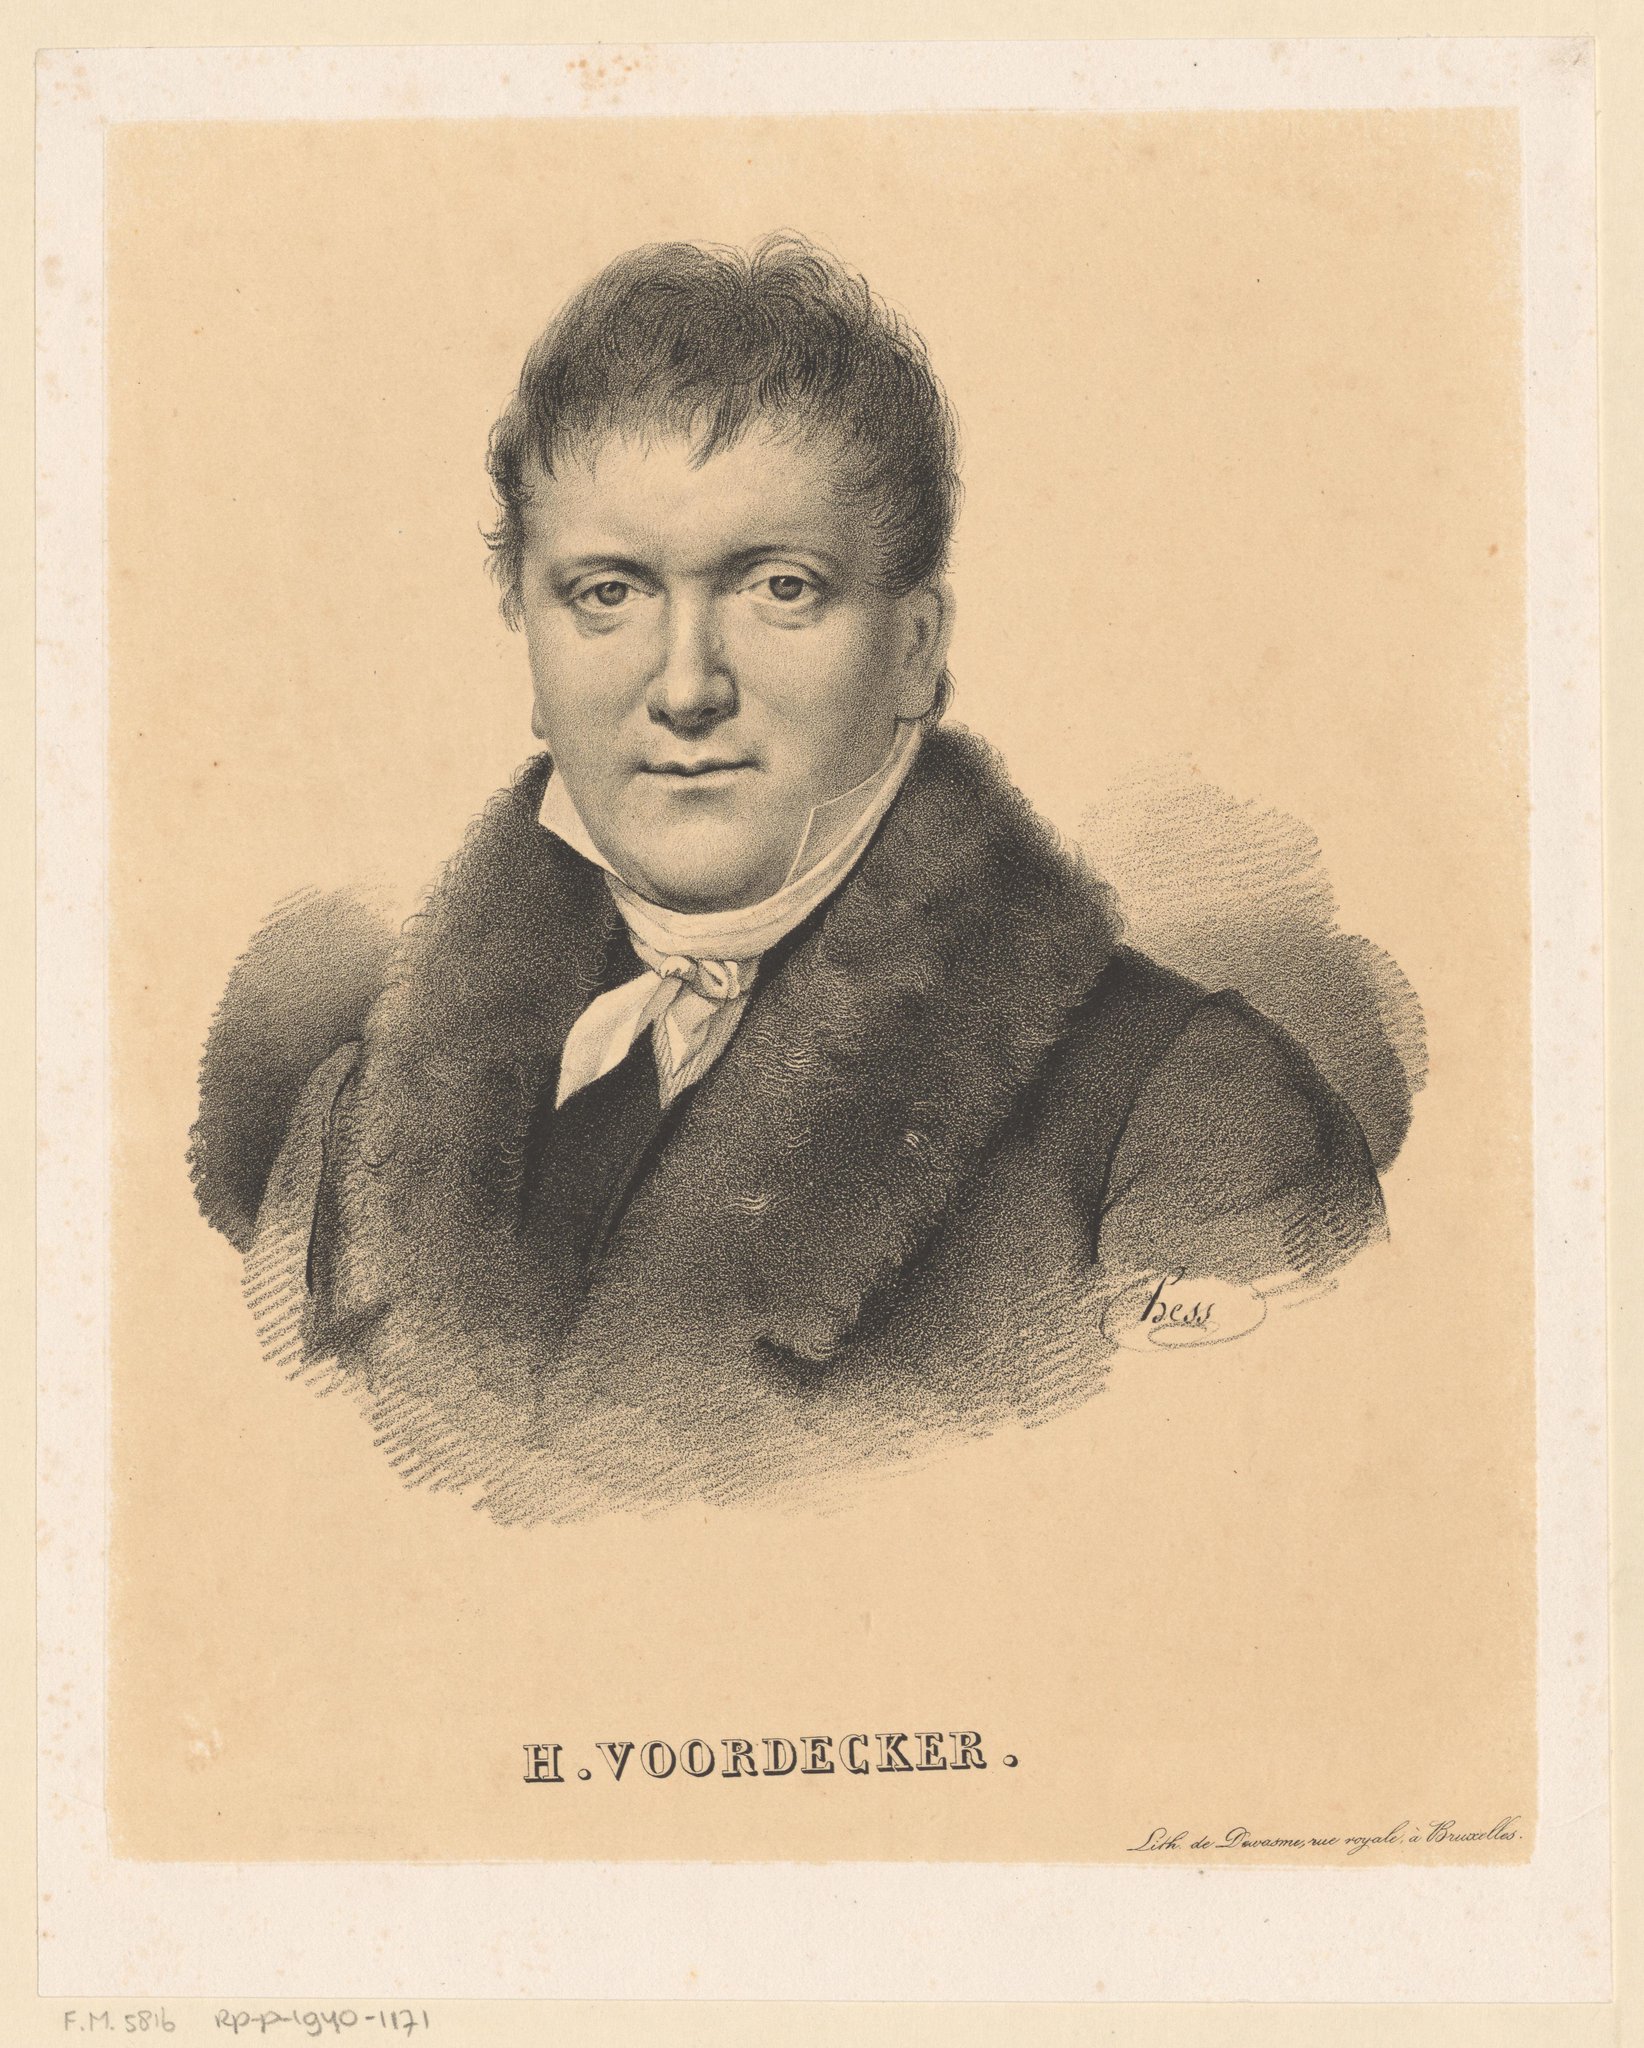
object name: print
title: Portret van Henri Voordecker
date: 1825-1827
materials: paper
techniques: tone lithography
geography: brussels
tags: painter, print maker, henri voordecker, historical persons, portrait, self-portrait of painter, portrait, self-portrait of graphic artist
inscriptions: collector's mark: Lugt 2760, collector's mark: Lugt 2228